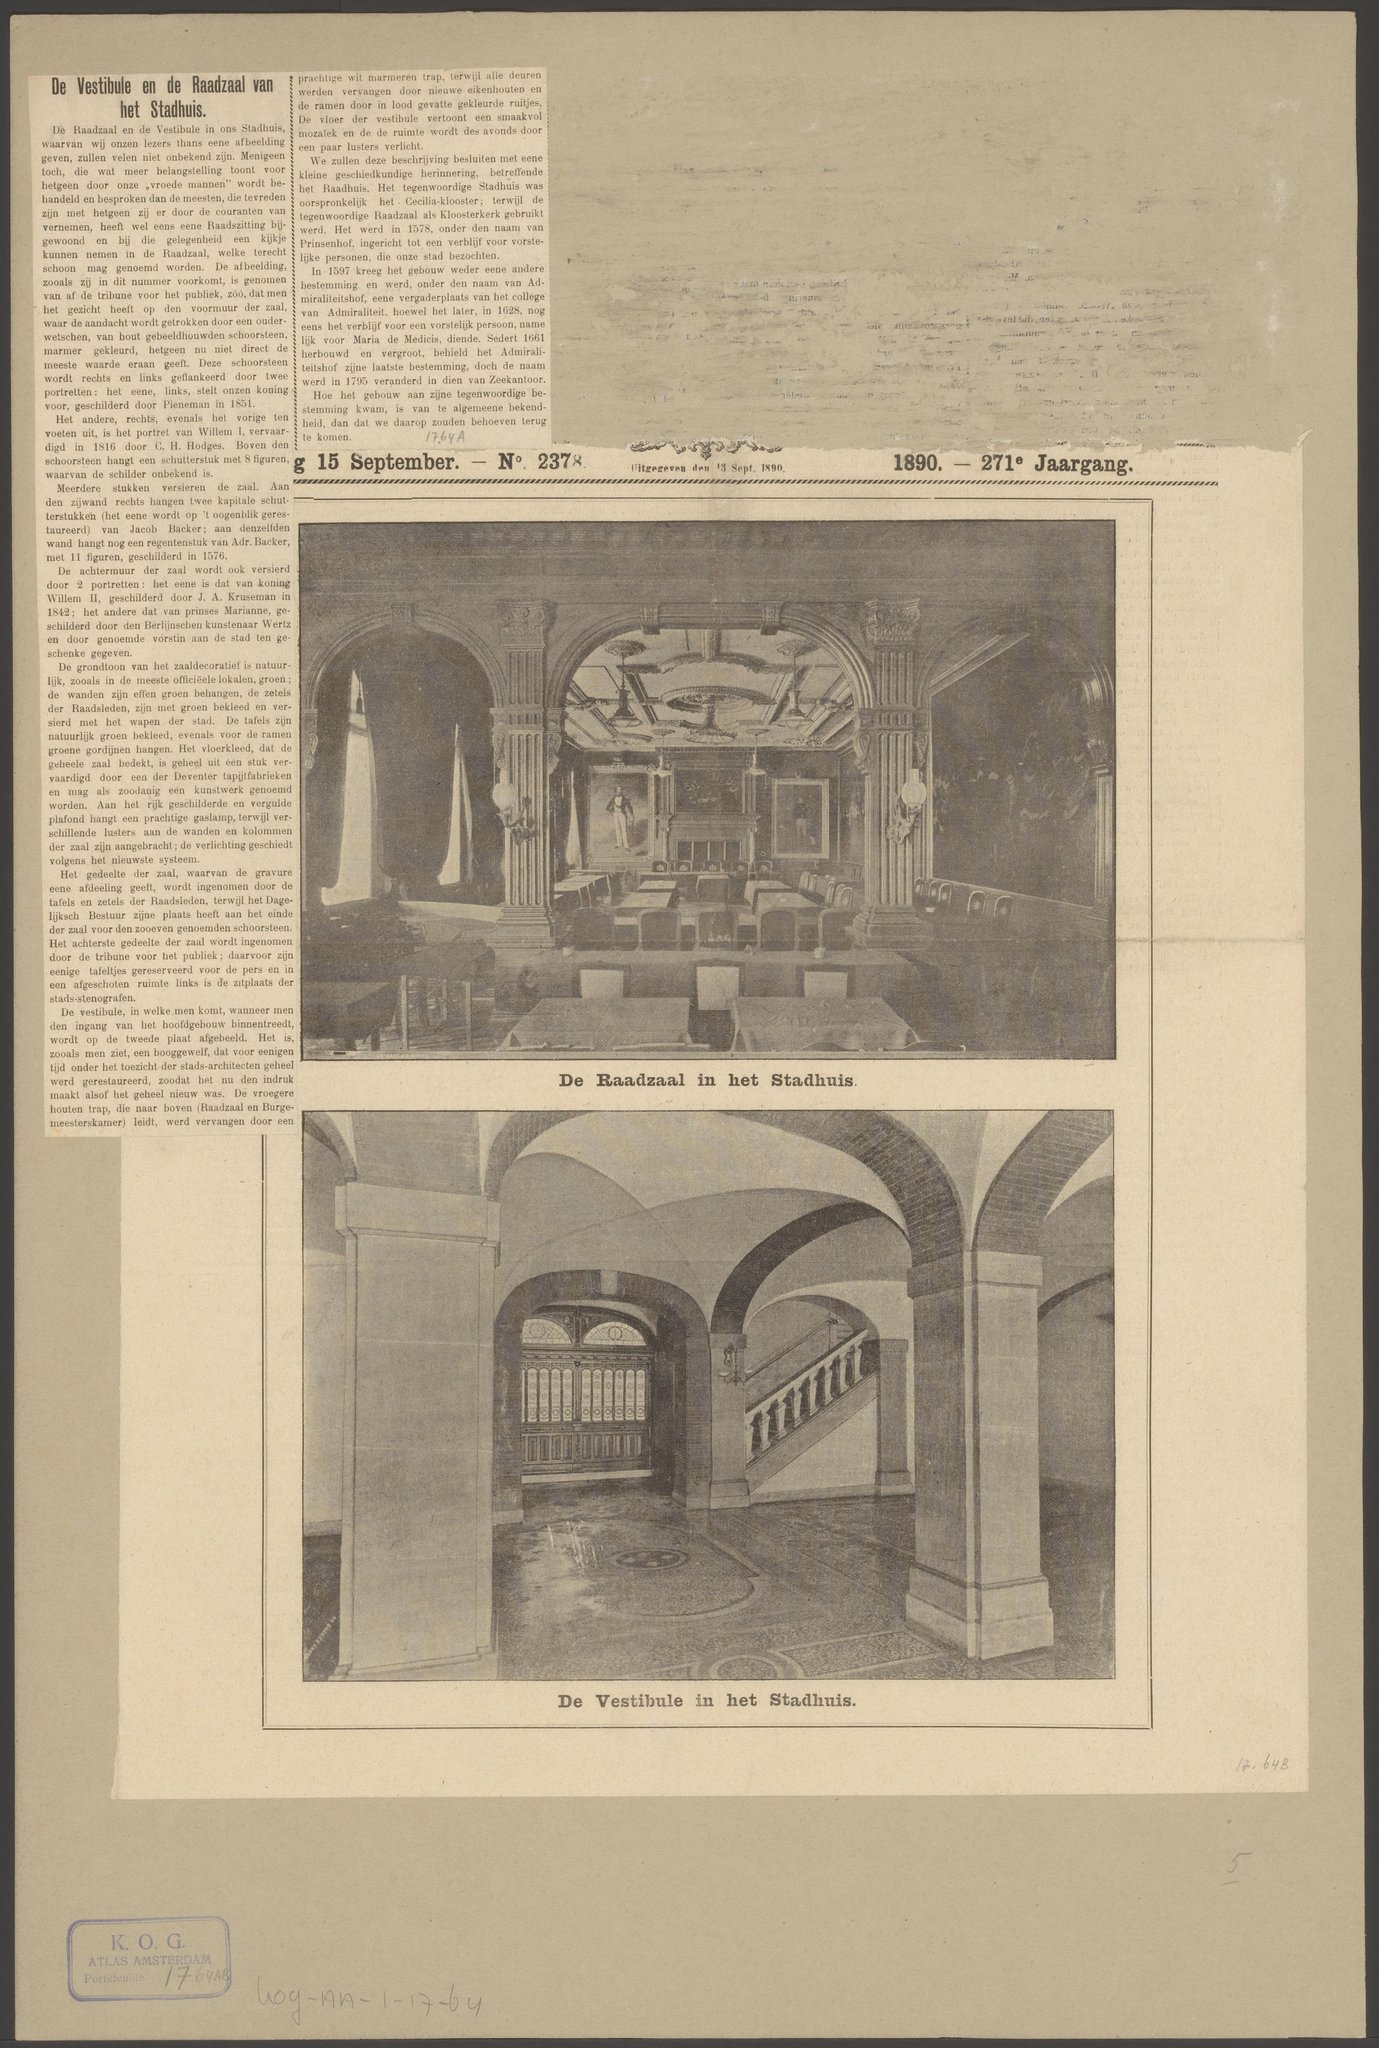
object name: photomechanical print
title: Gezichten op de Raadzaal en de Vestibule van het stadhuis op het Prinsenhof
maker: Anonymous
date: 1890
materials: paper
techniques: letterpress printing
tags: townhall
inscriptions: collector's mark: ‘17.64AB’ Lugt 1641b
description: Onderwerpsrubriek binnen de Atlas Amsterdam: Nieuwe Stadhuis, van binnen: Vaartuigen en Gebouwen ten dienste der Stedelijke Regeering en Administratie; Stadhuis (Prinsenhof).